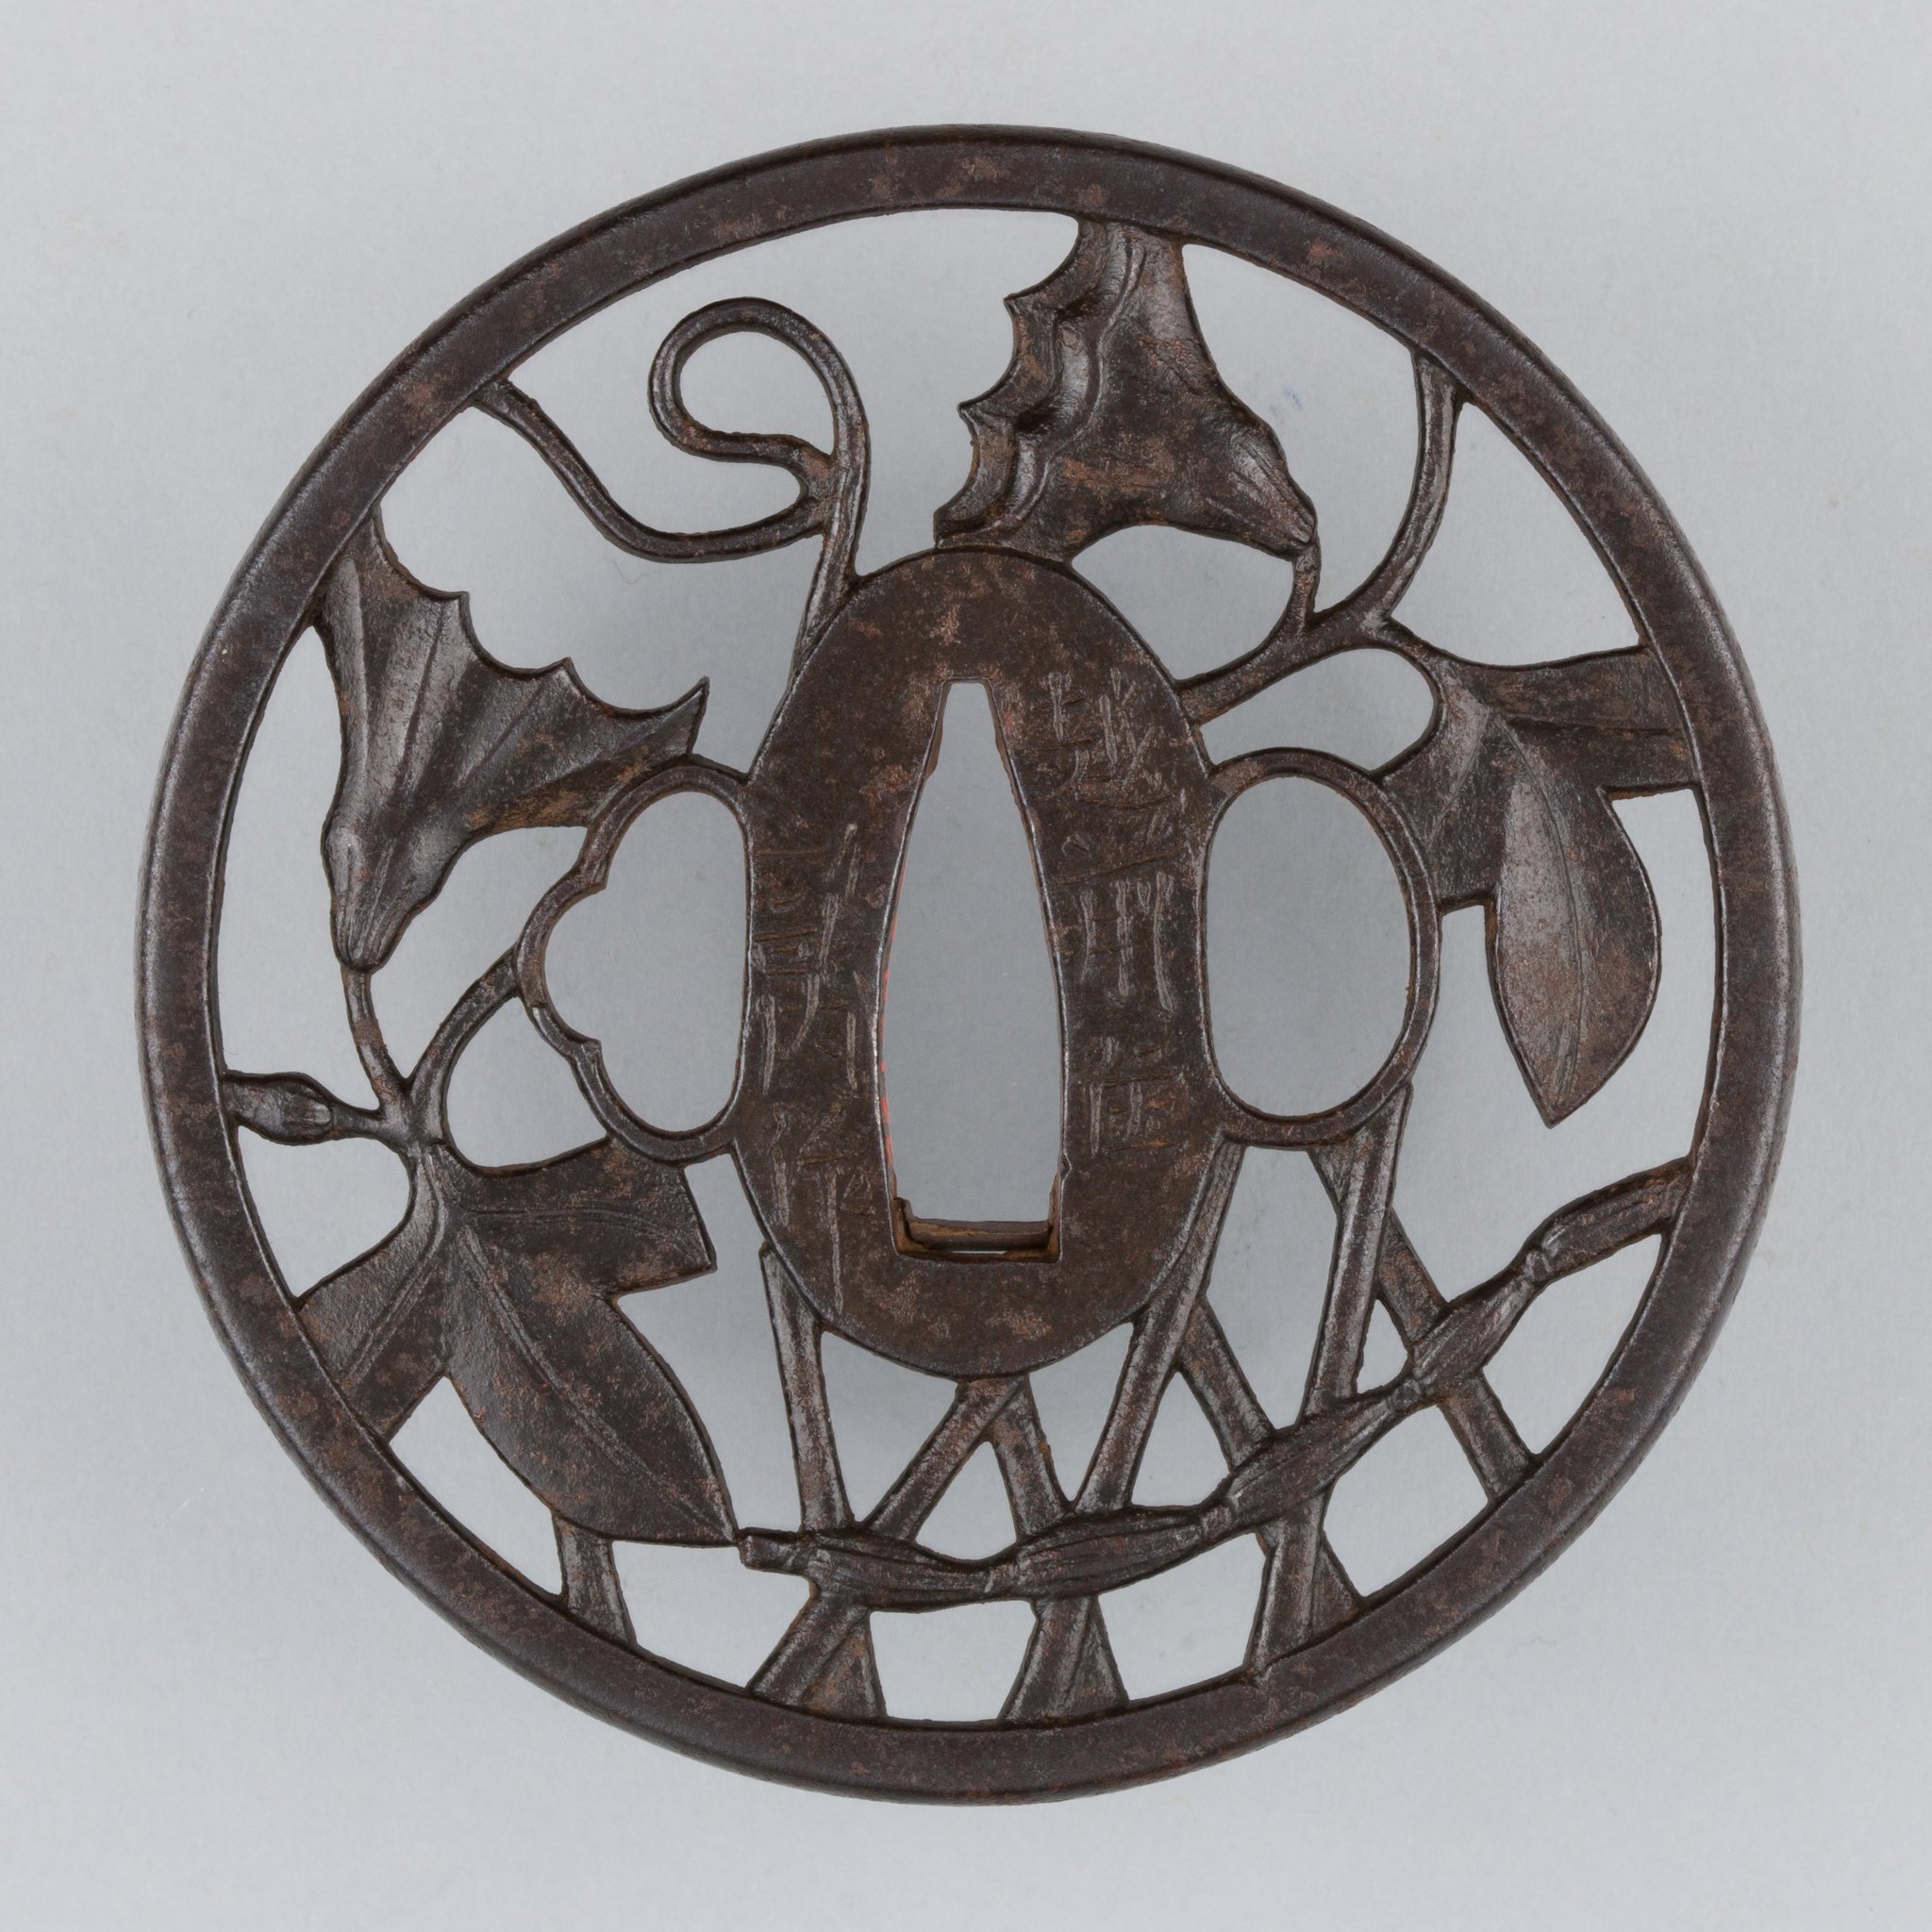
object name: sword guard tsuba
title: Sword Guard (Tsuba)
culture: japanese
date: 1601-1800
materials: copper, iron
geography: japan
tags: flowers